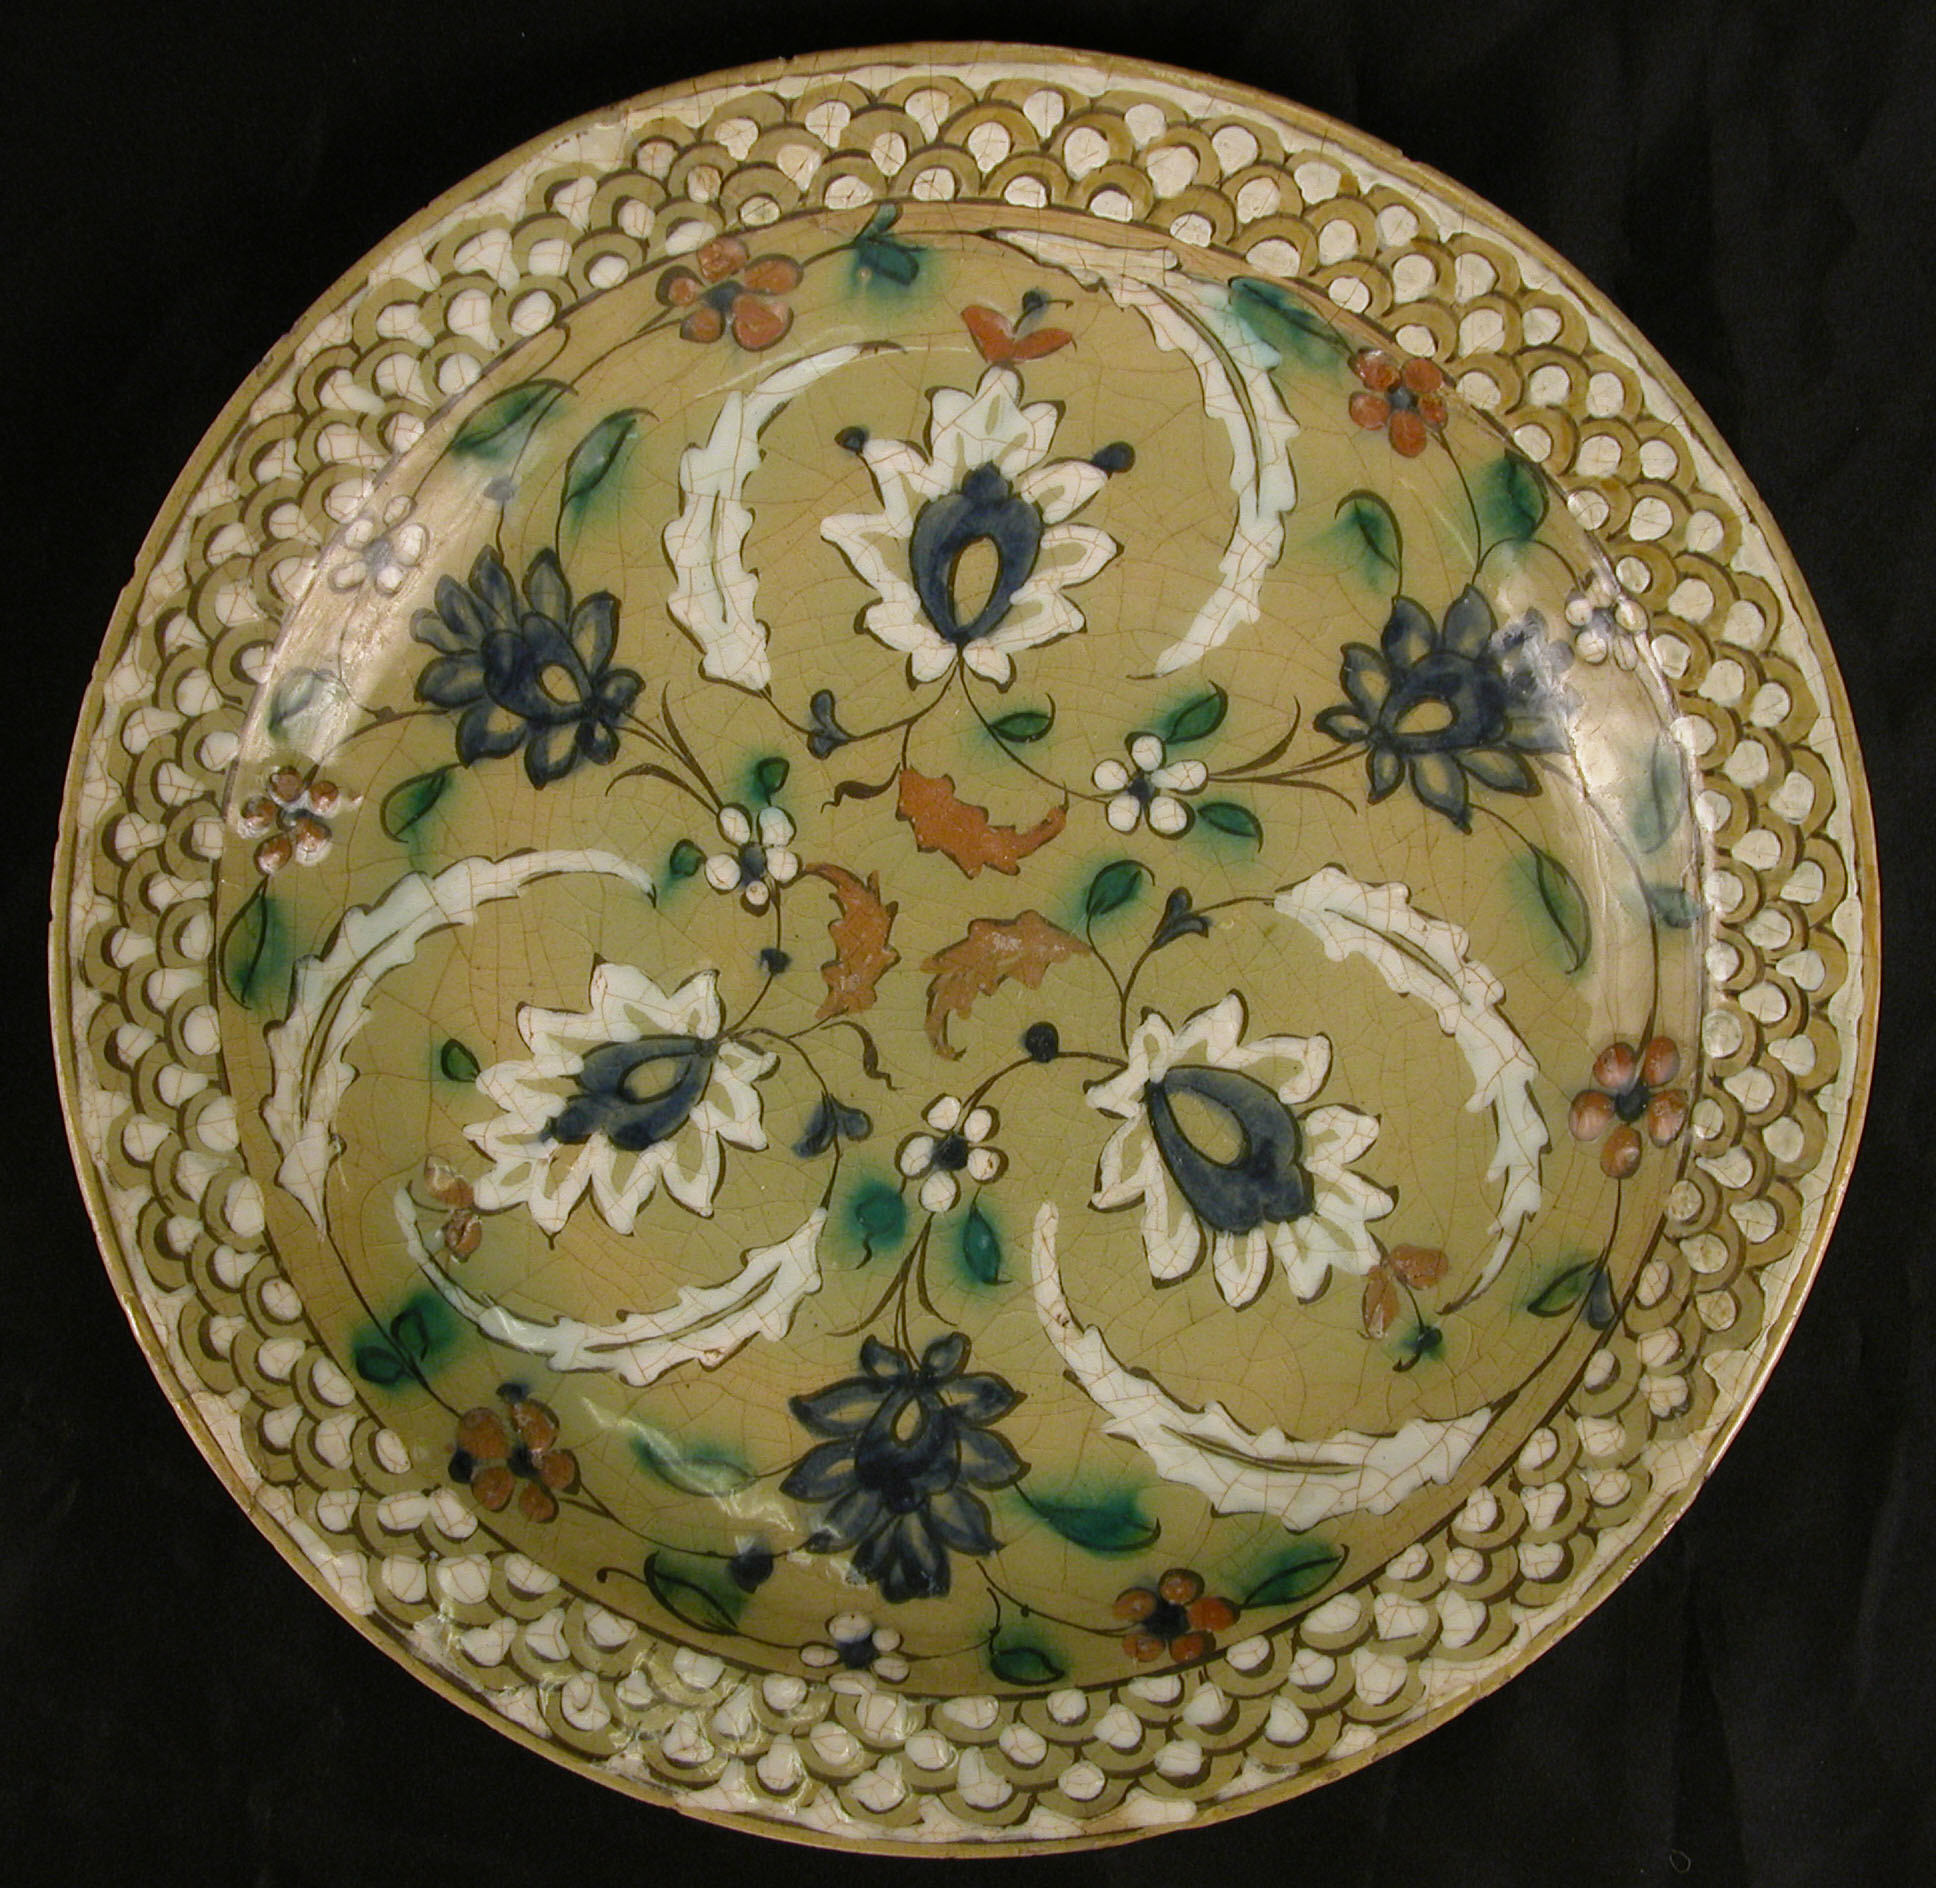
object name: dish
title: Dish with Floral Designs on an Olive Background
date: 1501-1700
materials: glaze, stonepaste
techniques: painting, polychrome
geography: iran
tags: flowers,leaves